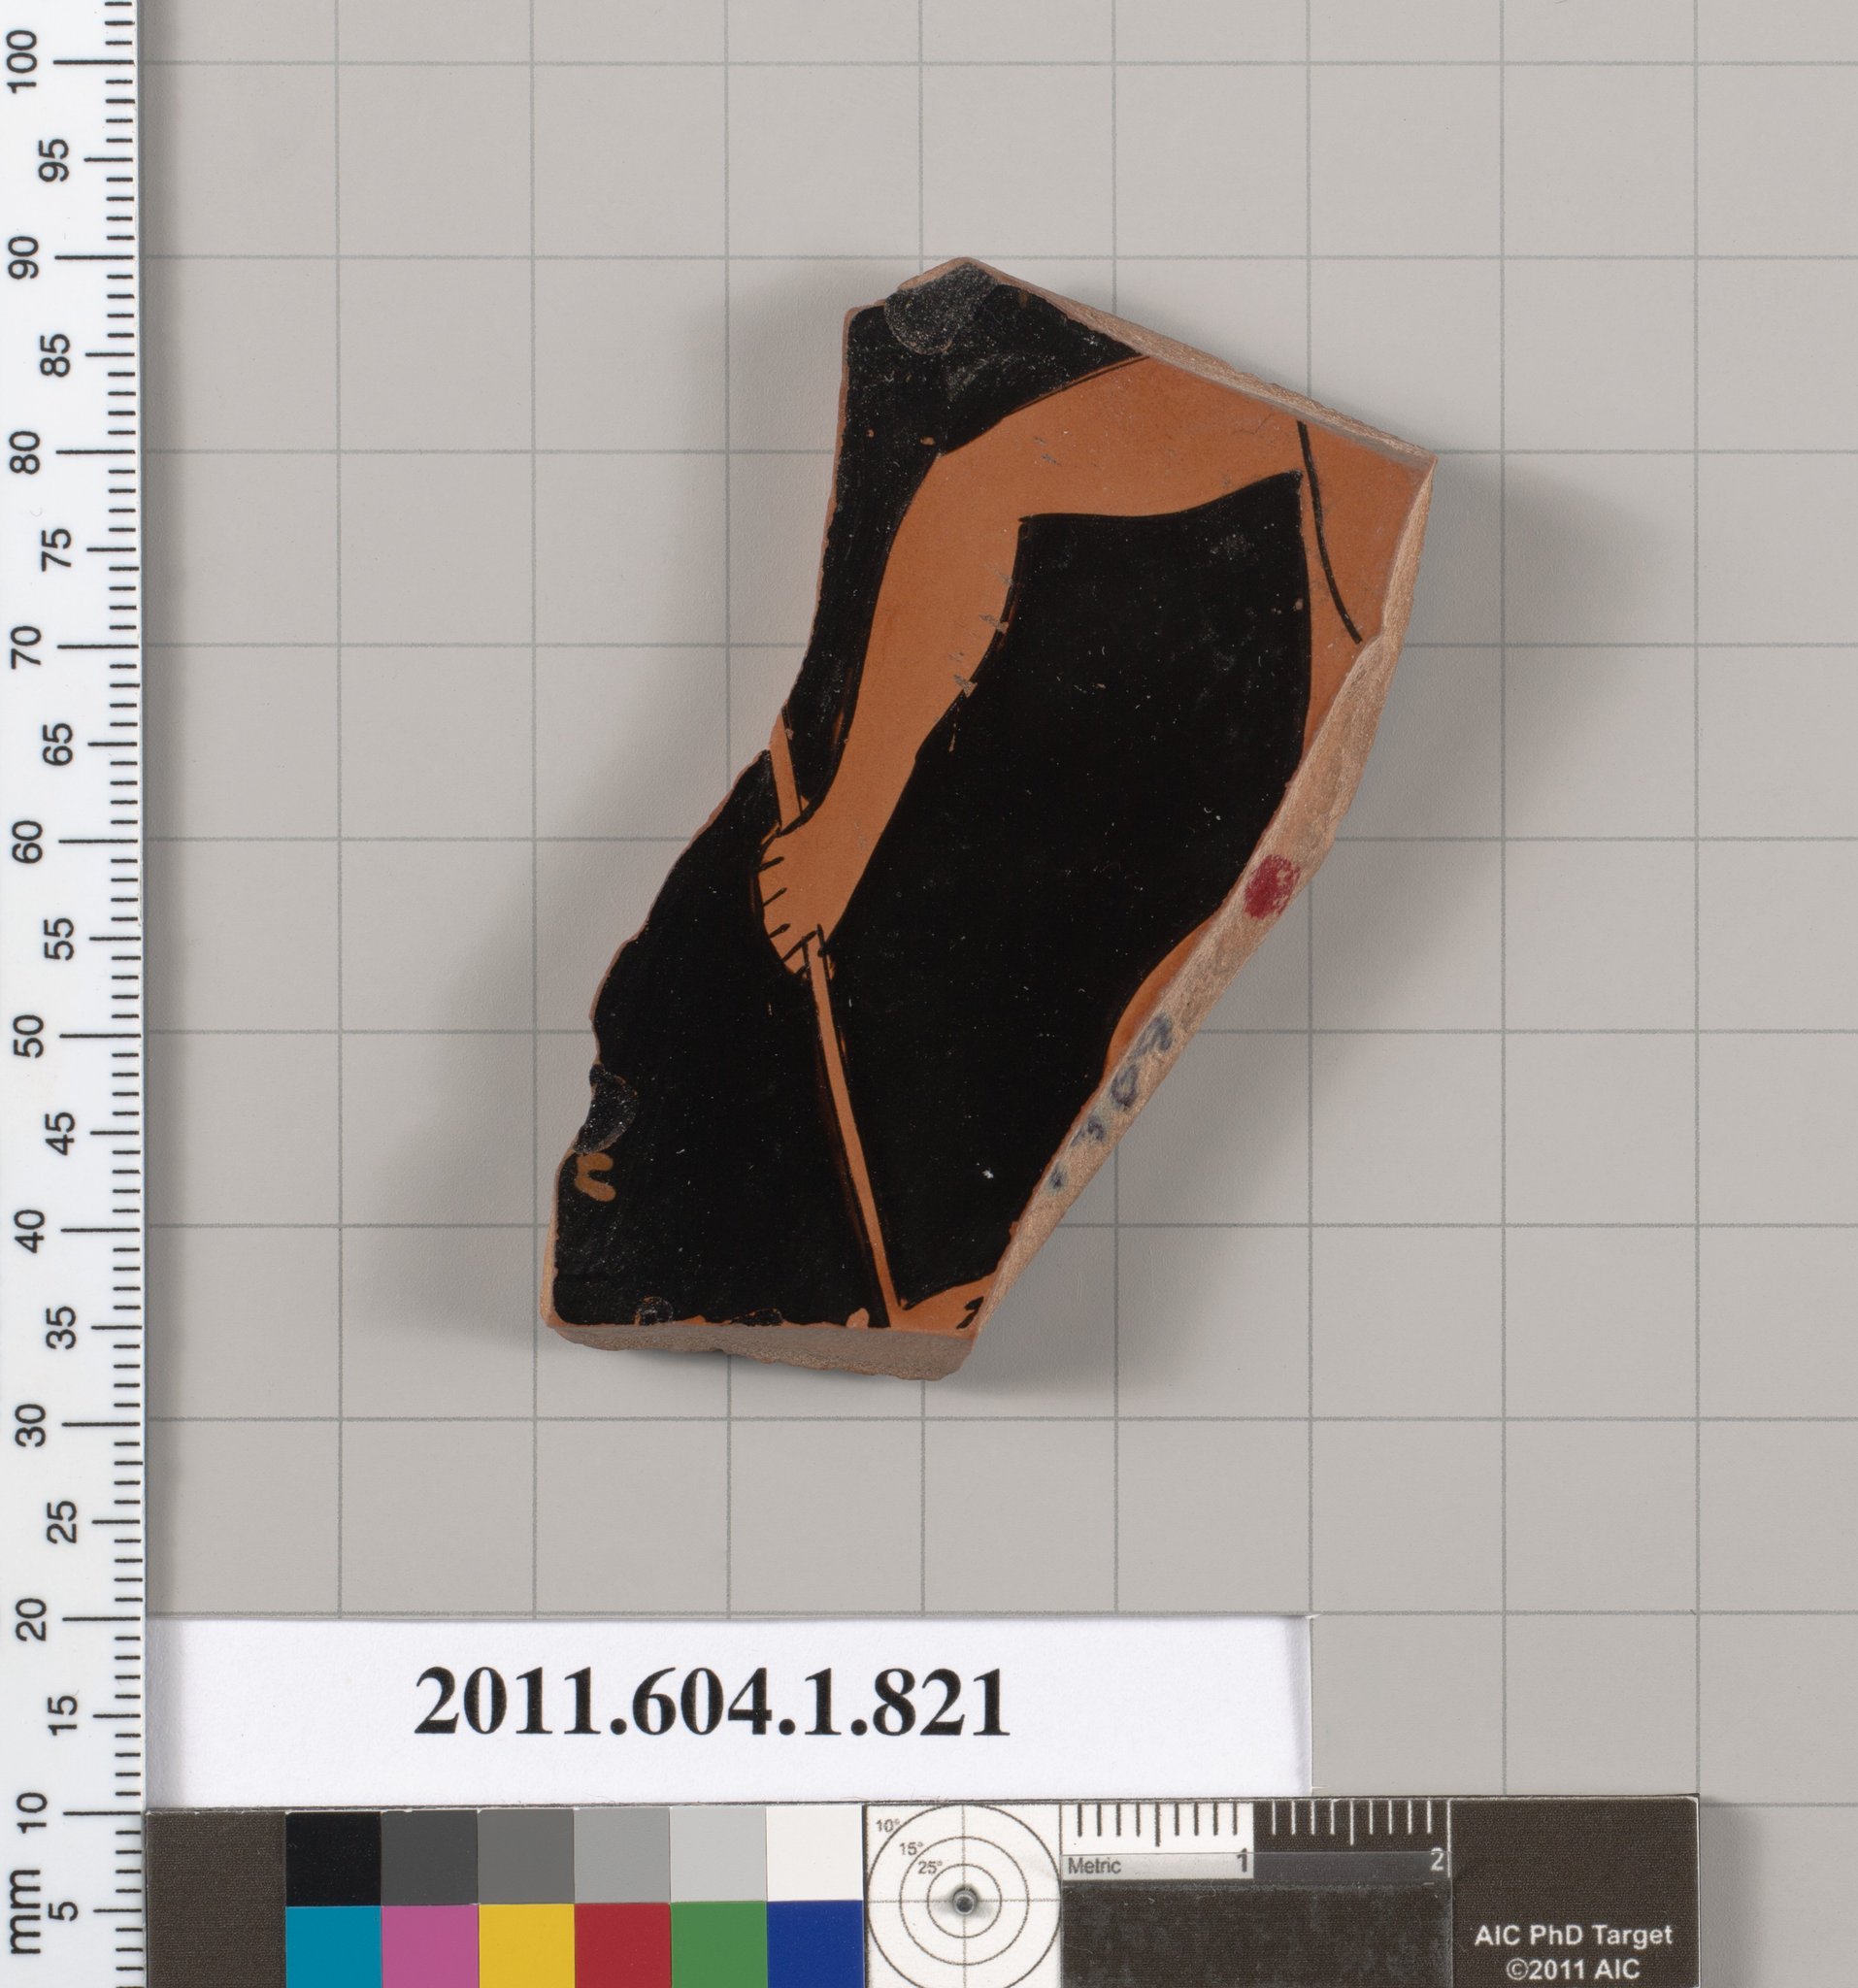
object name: kylix fragment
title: Terracotta fragment of a kylix (drinking cup)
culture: greek, attic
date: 475-451 BCE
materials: terracotta